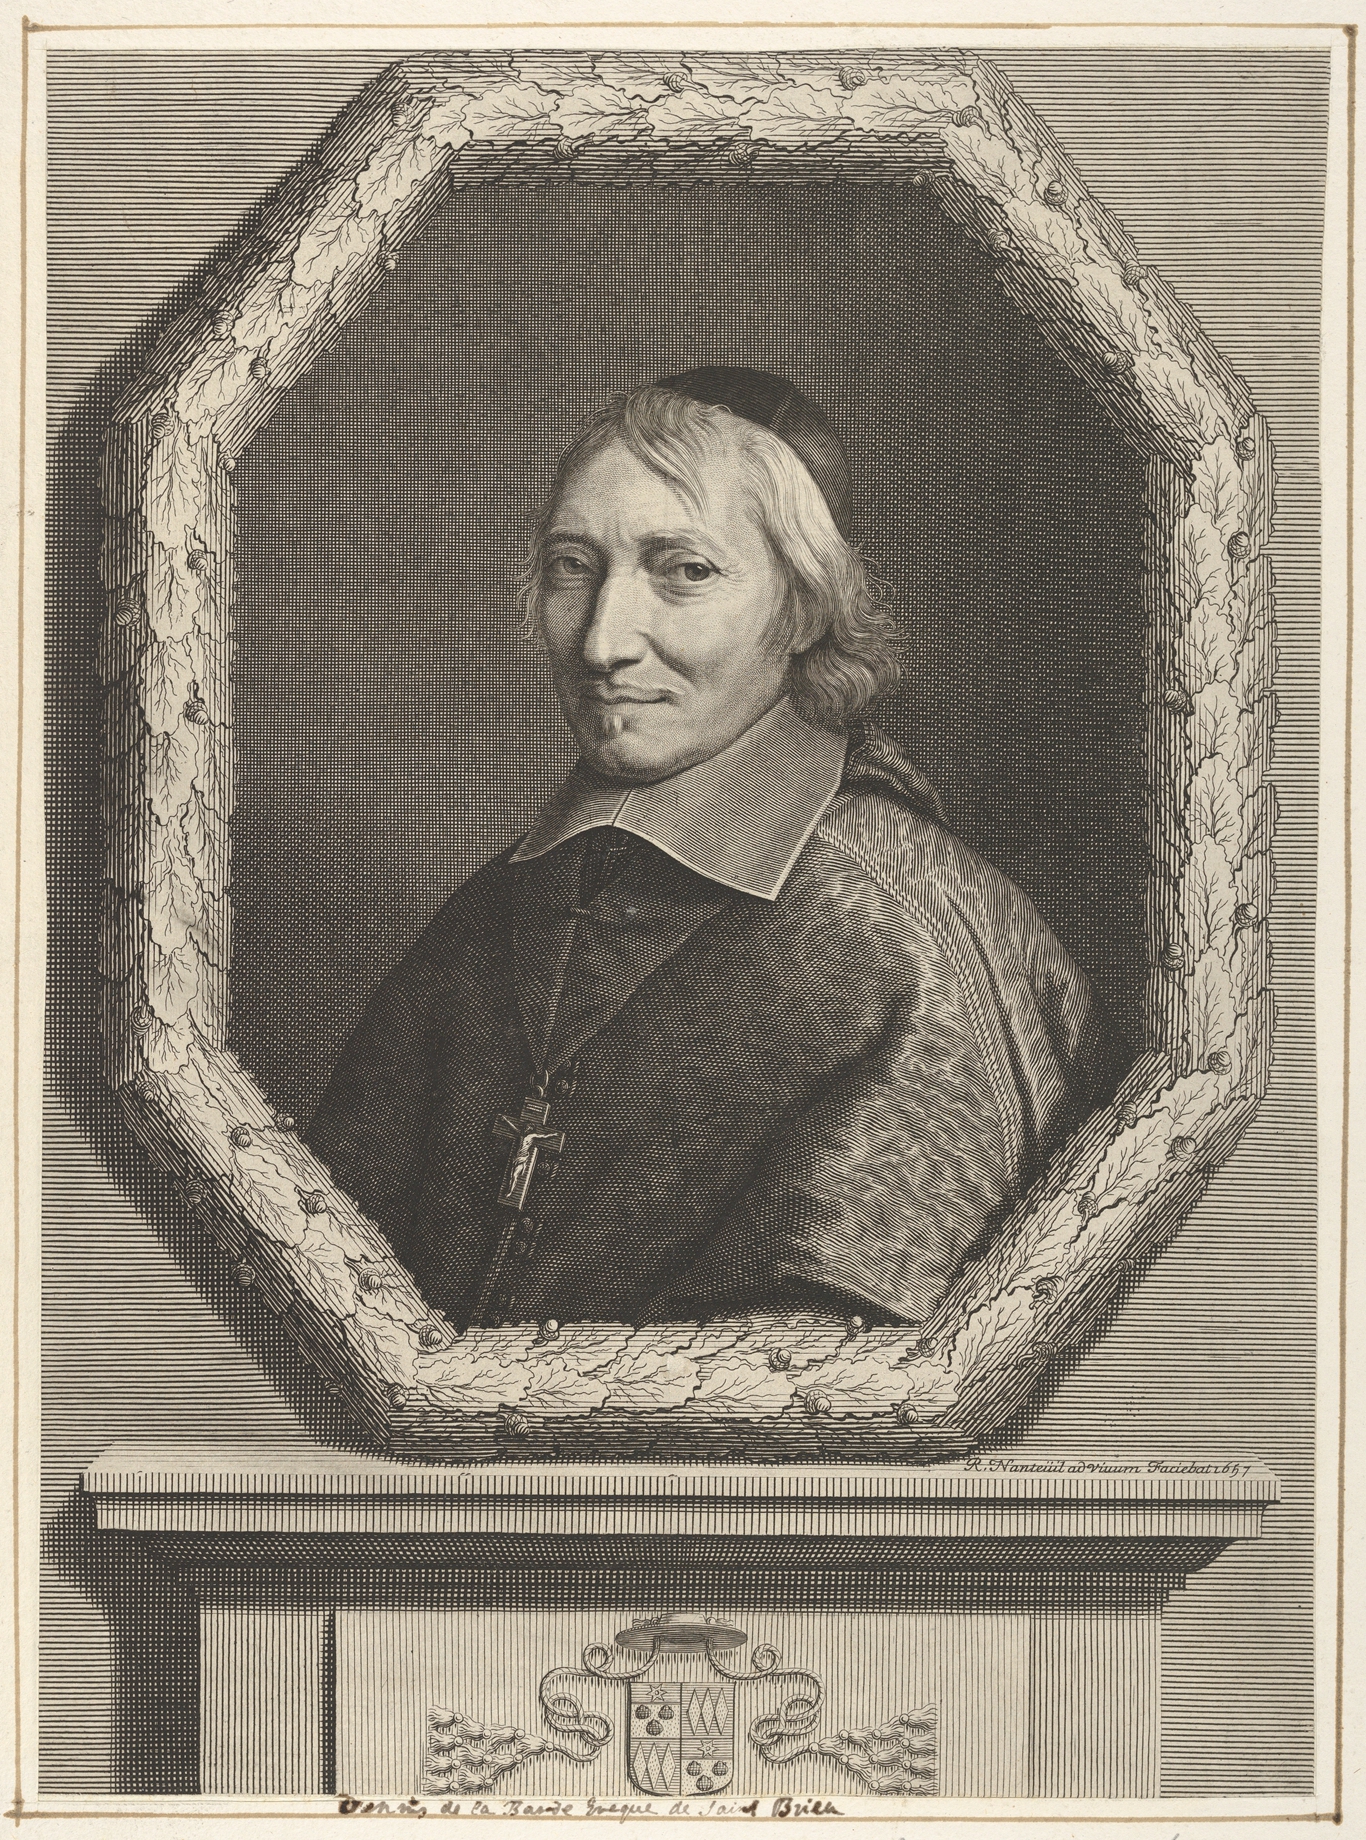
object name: print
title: Denis de La Barde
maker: robert nanteuil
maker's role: artist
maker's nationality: french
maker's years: 1623-1678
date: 1657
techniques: engraving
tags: men,portraits,cross